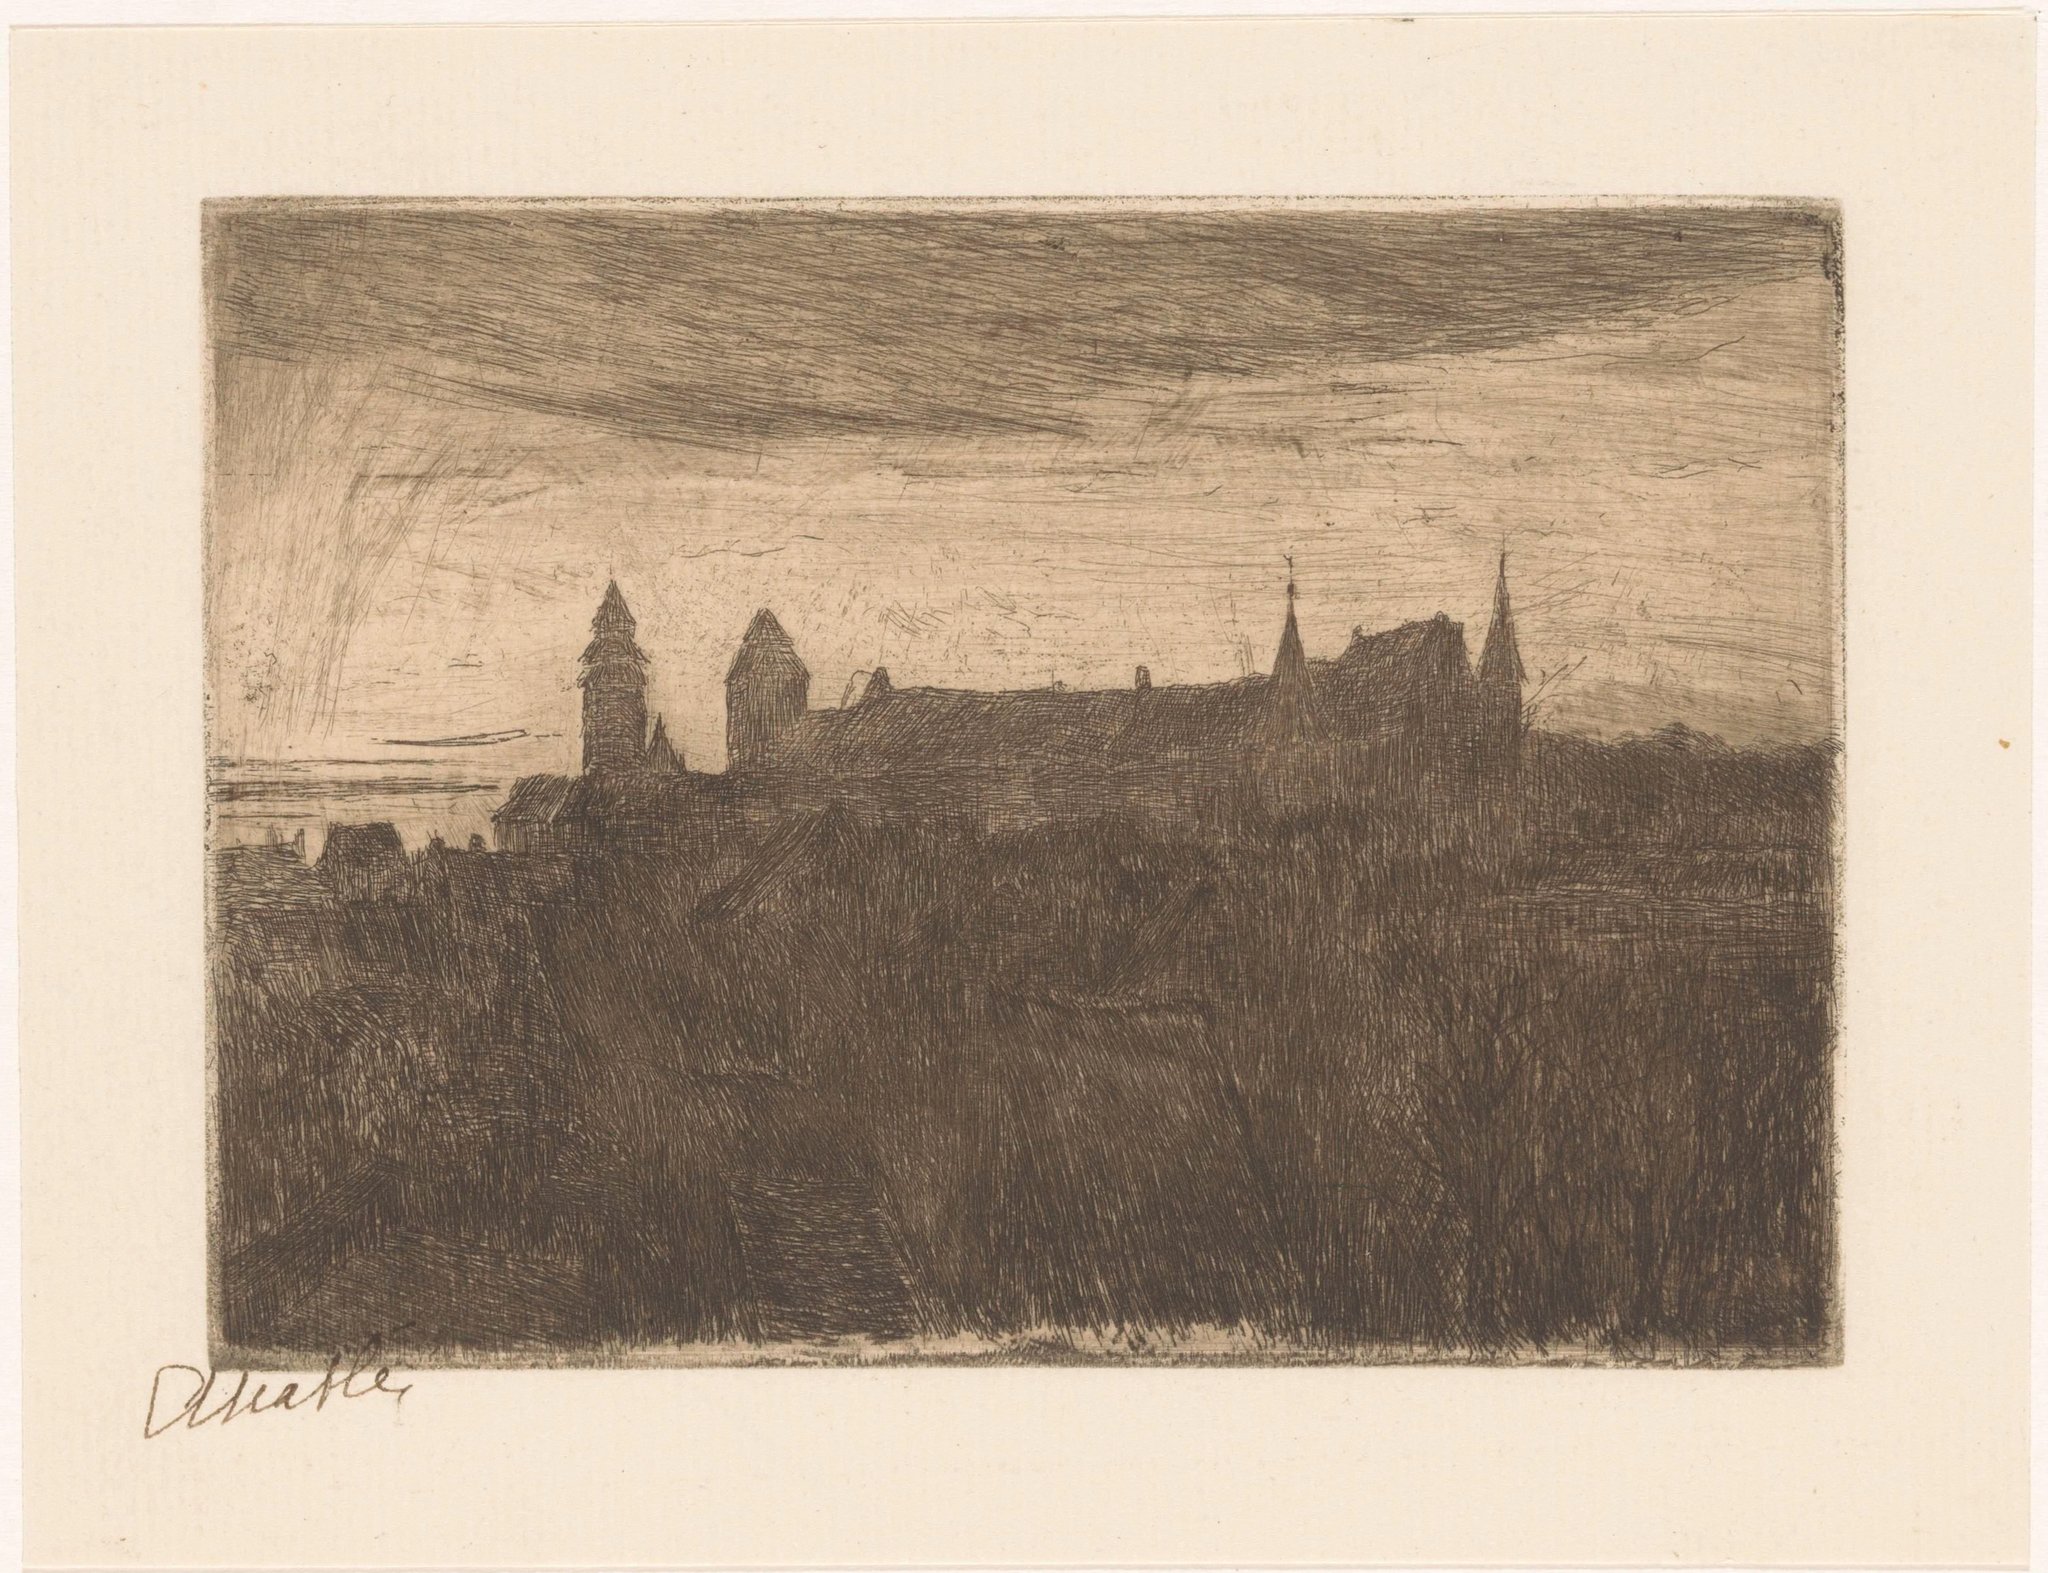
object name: print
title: Neurenberg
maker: etha fles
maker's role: print maker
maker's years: 1857-1948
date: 1867-1910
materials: paper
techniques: drypoint, intaglio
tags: prospect of city, town panorama, silhouette of city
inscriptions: collector's mark: Lugt 2228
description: Het silhouet van de stad Neurenberg in de schemer, met onder meer kerktorens en Kasteel Neurenberg.